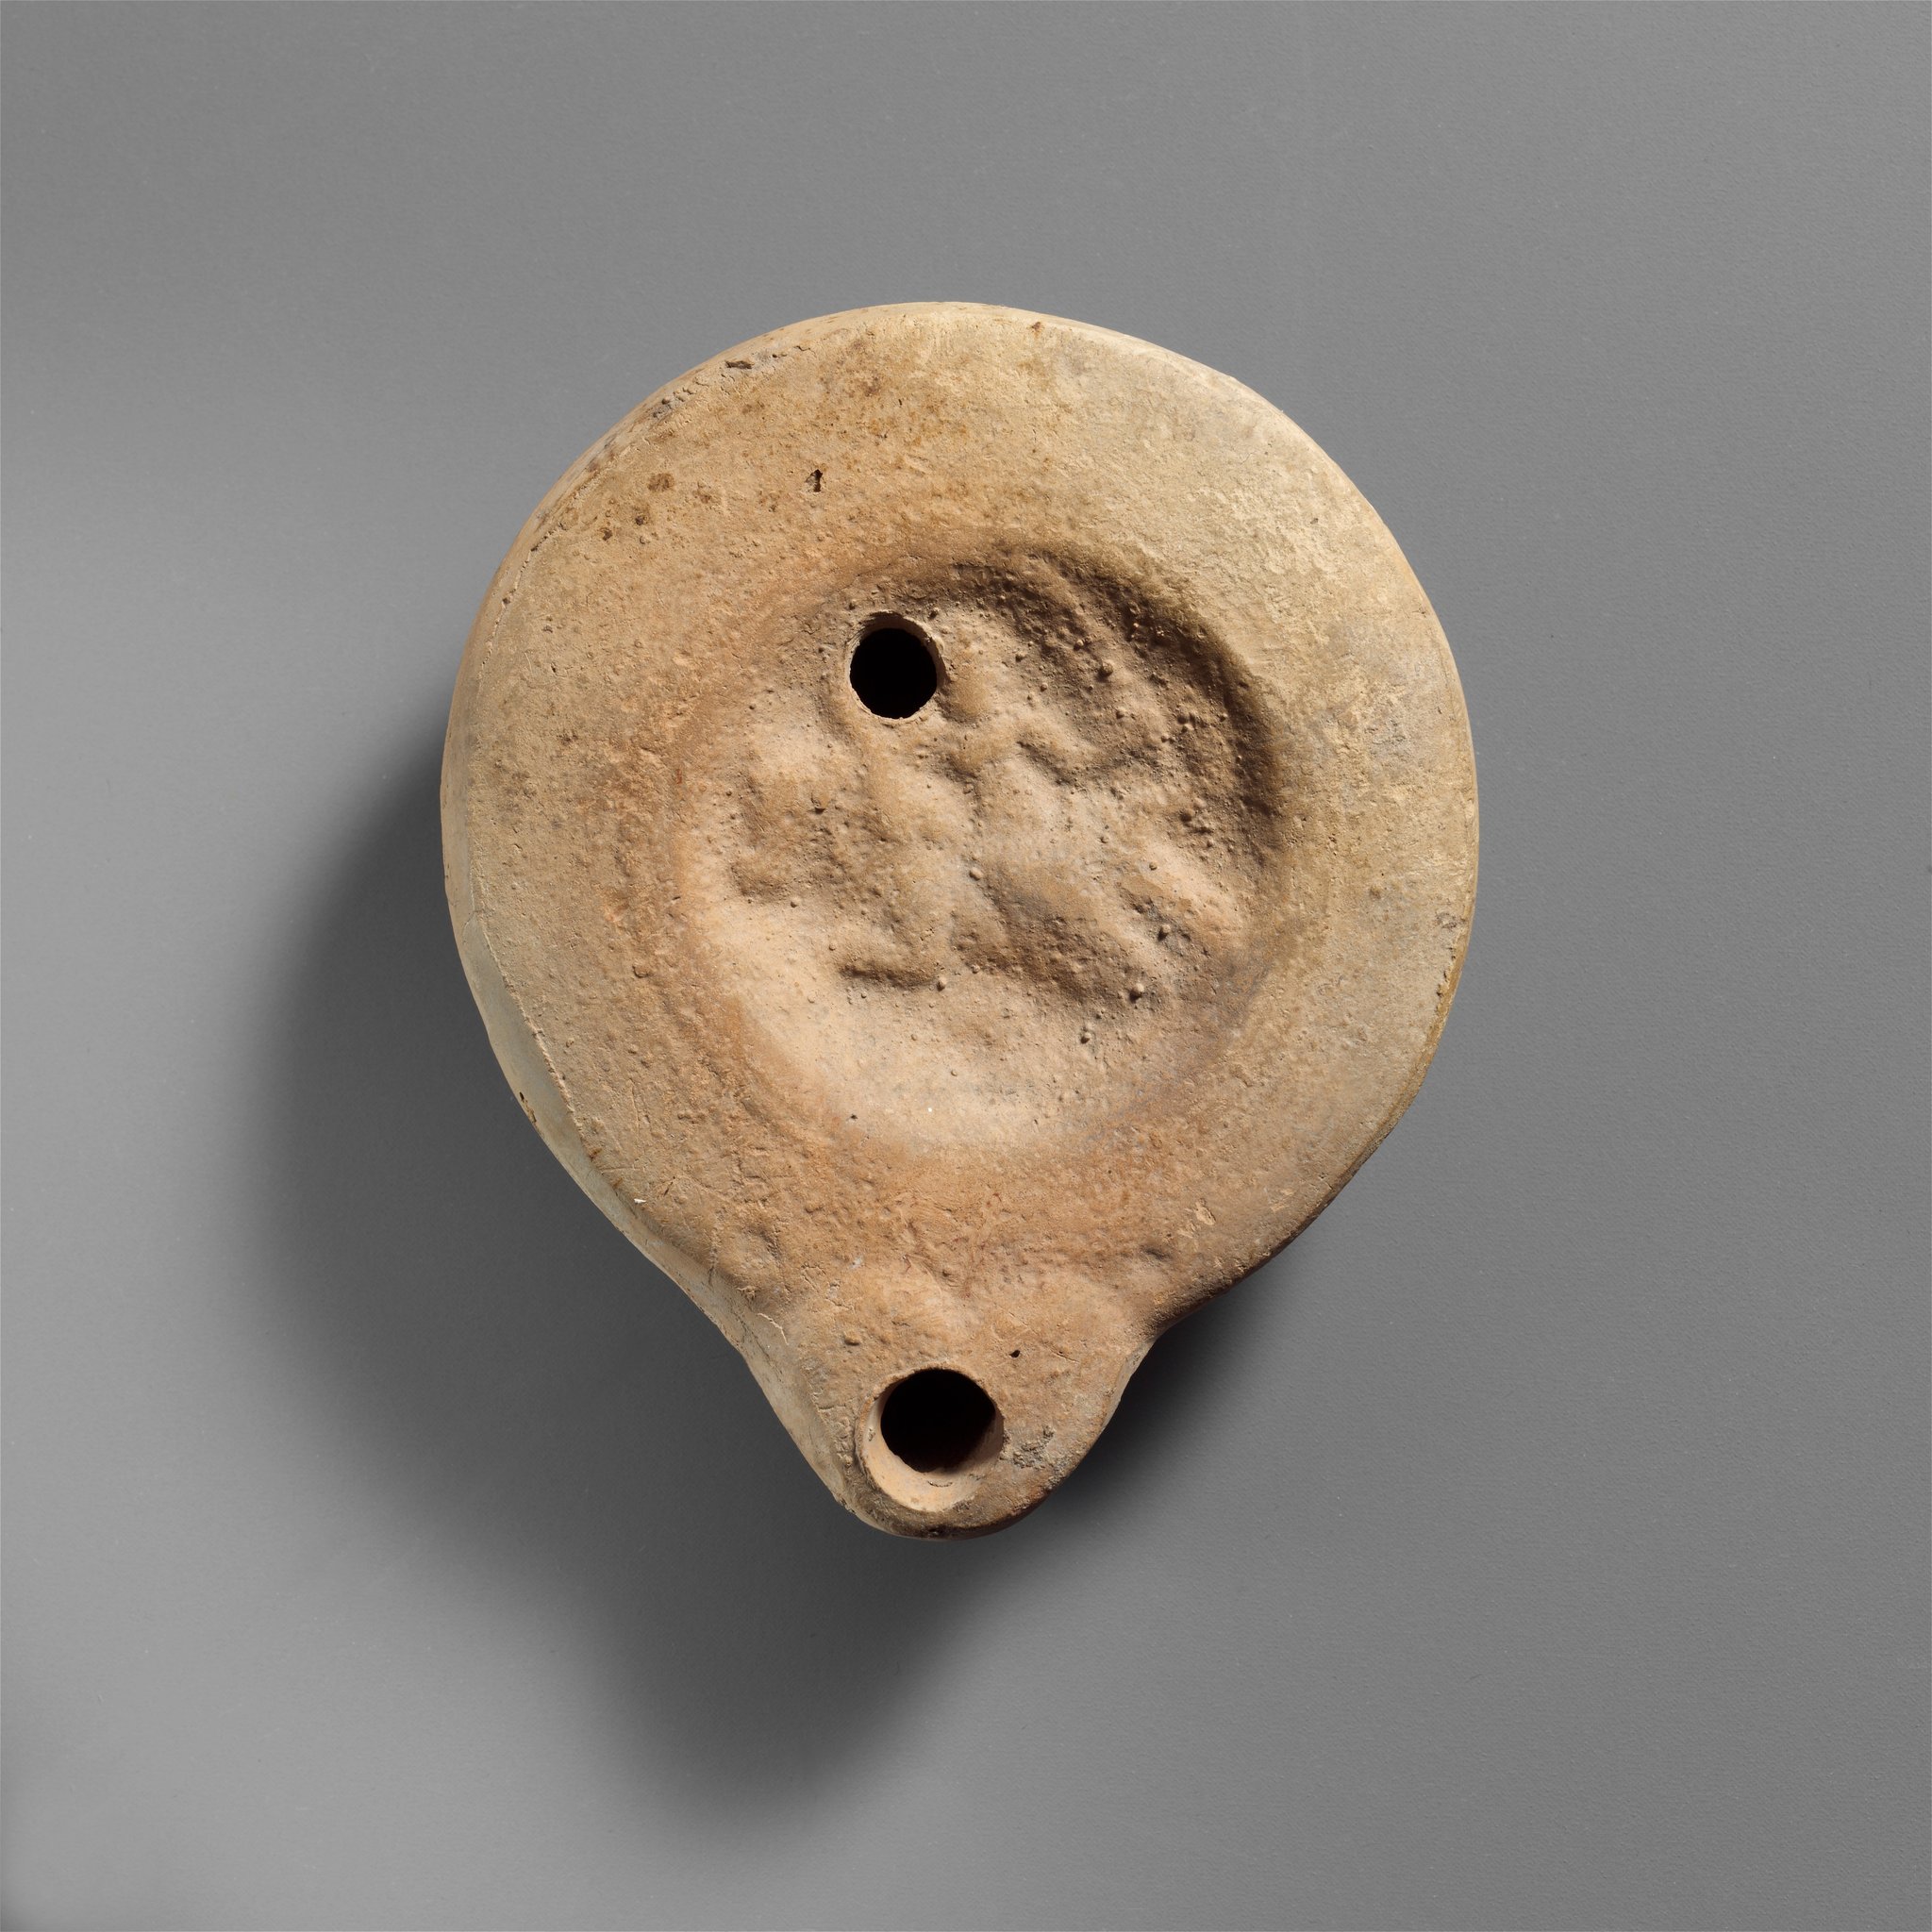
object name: lamp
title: Terracotta oil lamp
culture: roman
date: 101-200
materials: terracotta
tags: europa,bulls